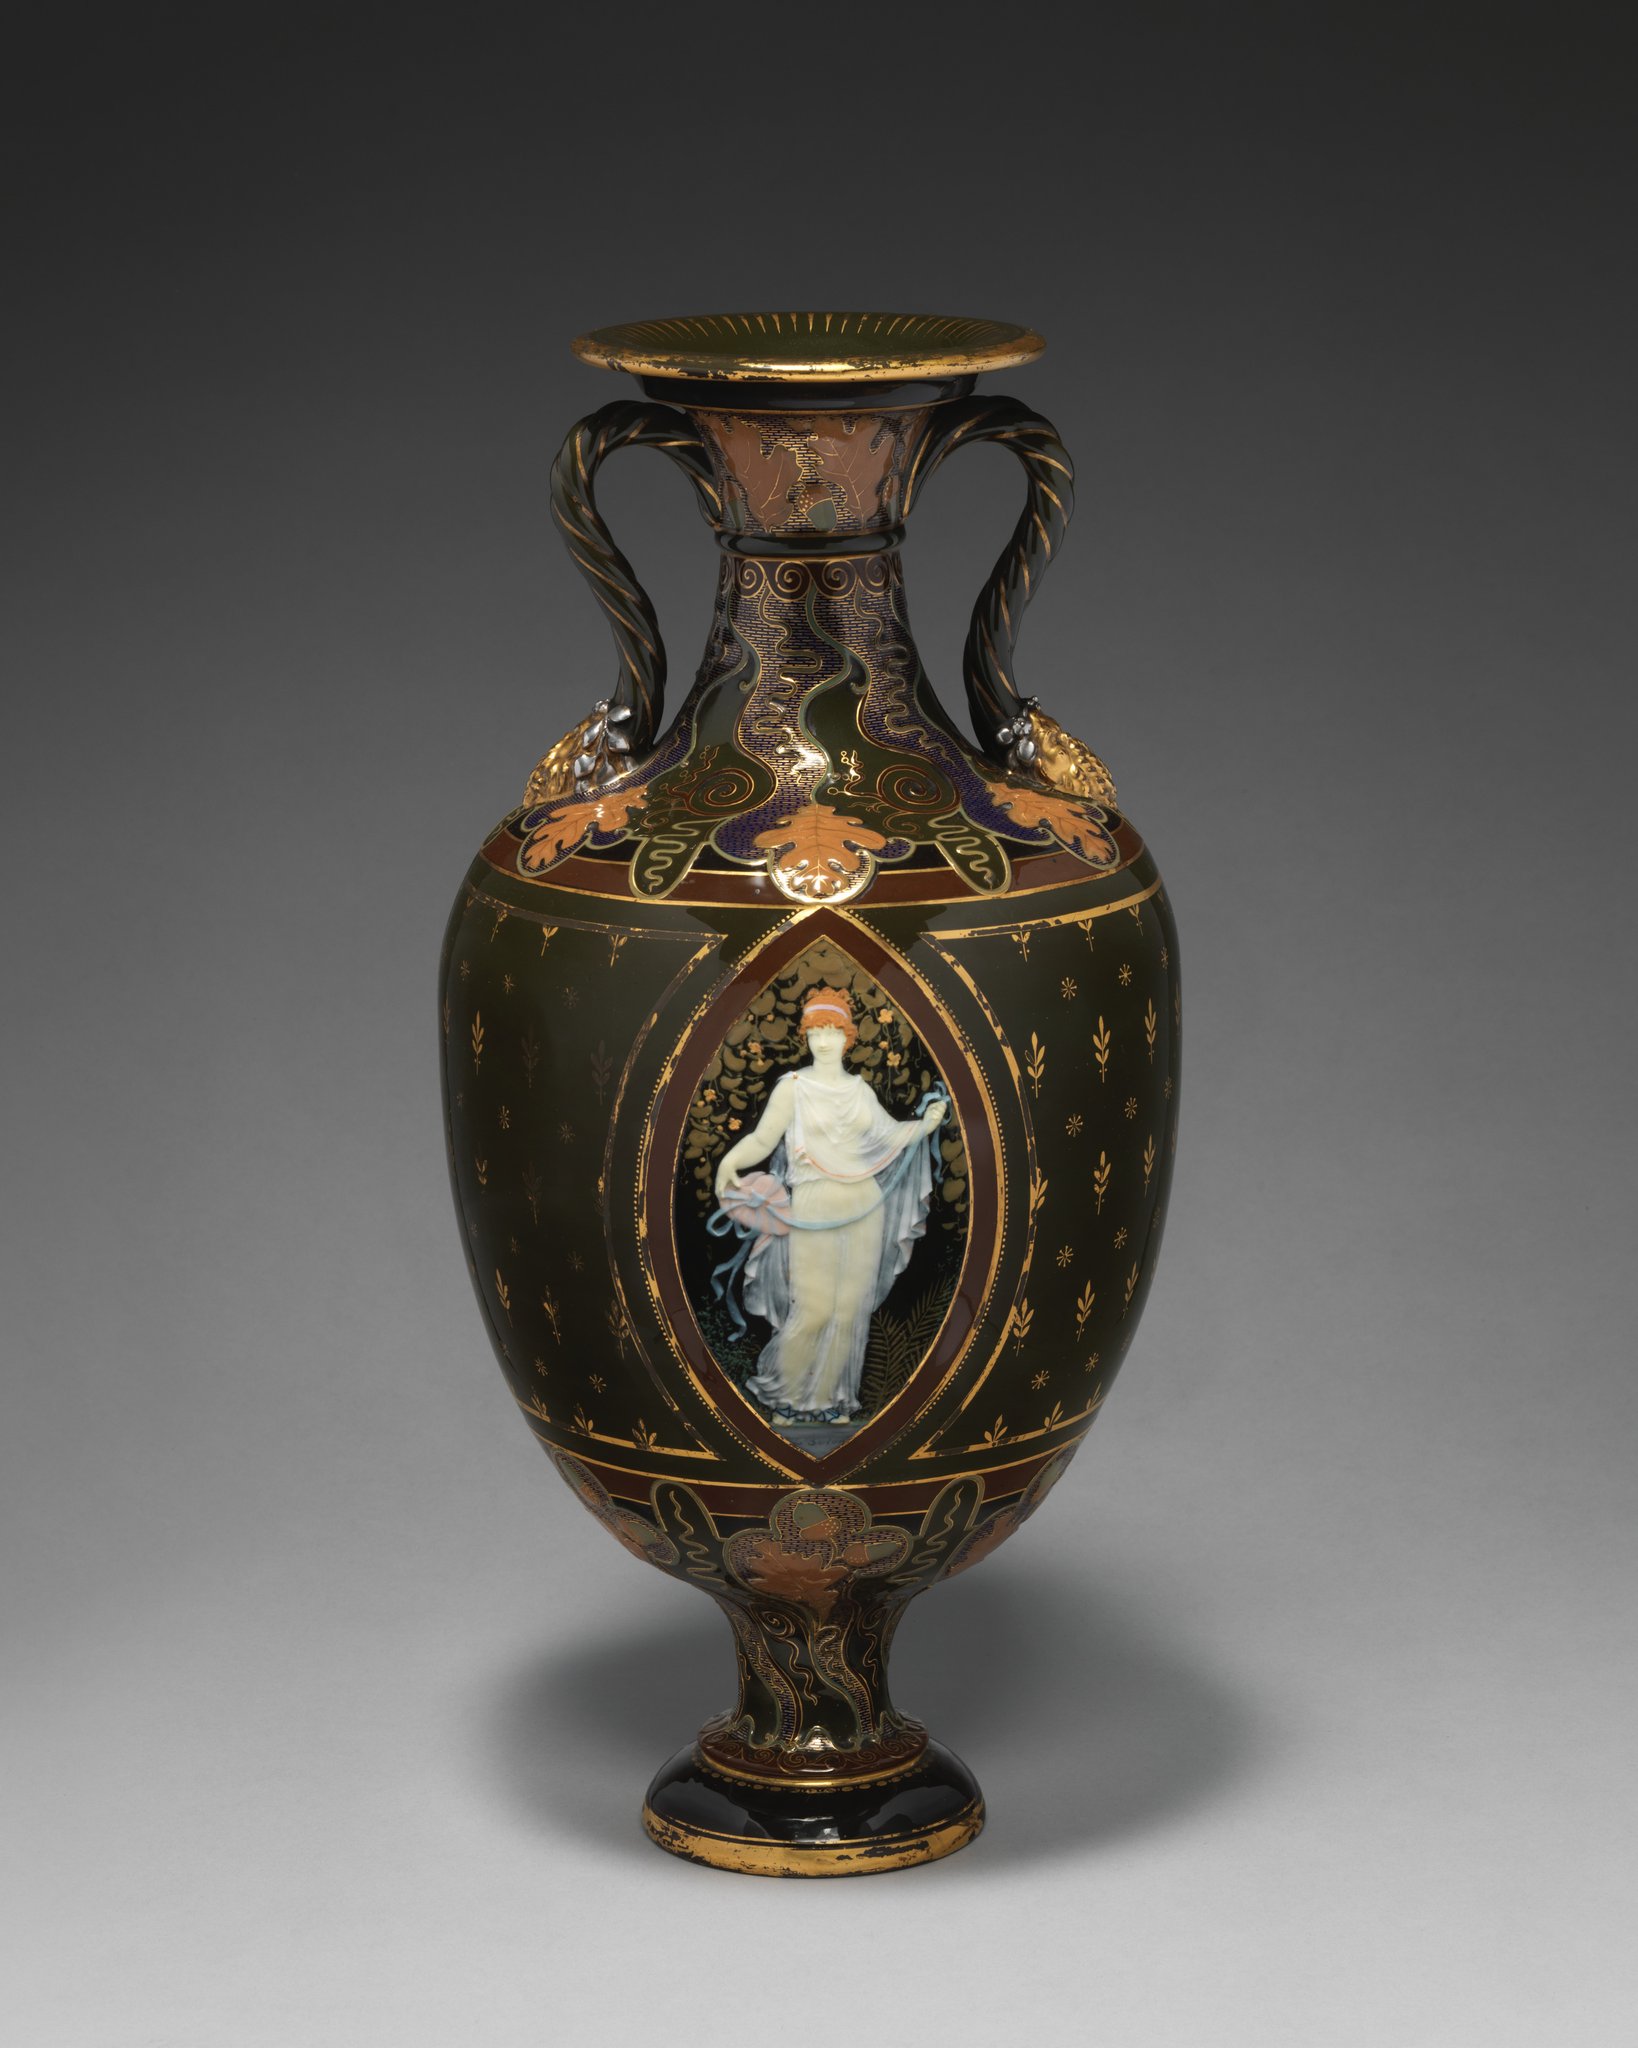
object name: vase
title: Olive-green ground vase with pâte-sur-pâte decoration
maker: minton(s)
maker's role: maker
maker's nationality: british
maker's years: 1793-2001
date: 1884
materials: bone china, enamel, platinum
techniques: gilding